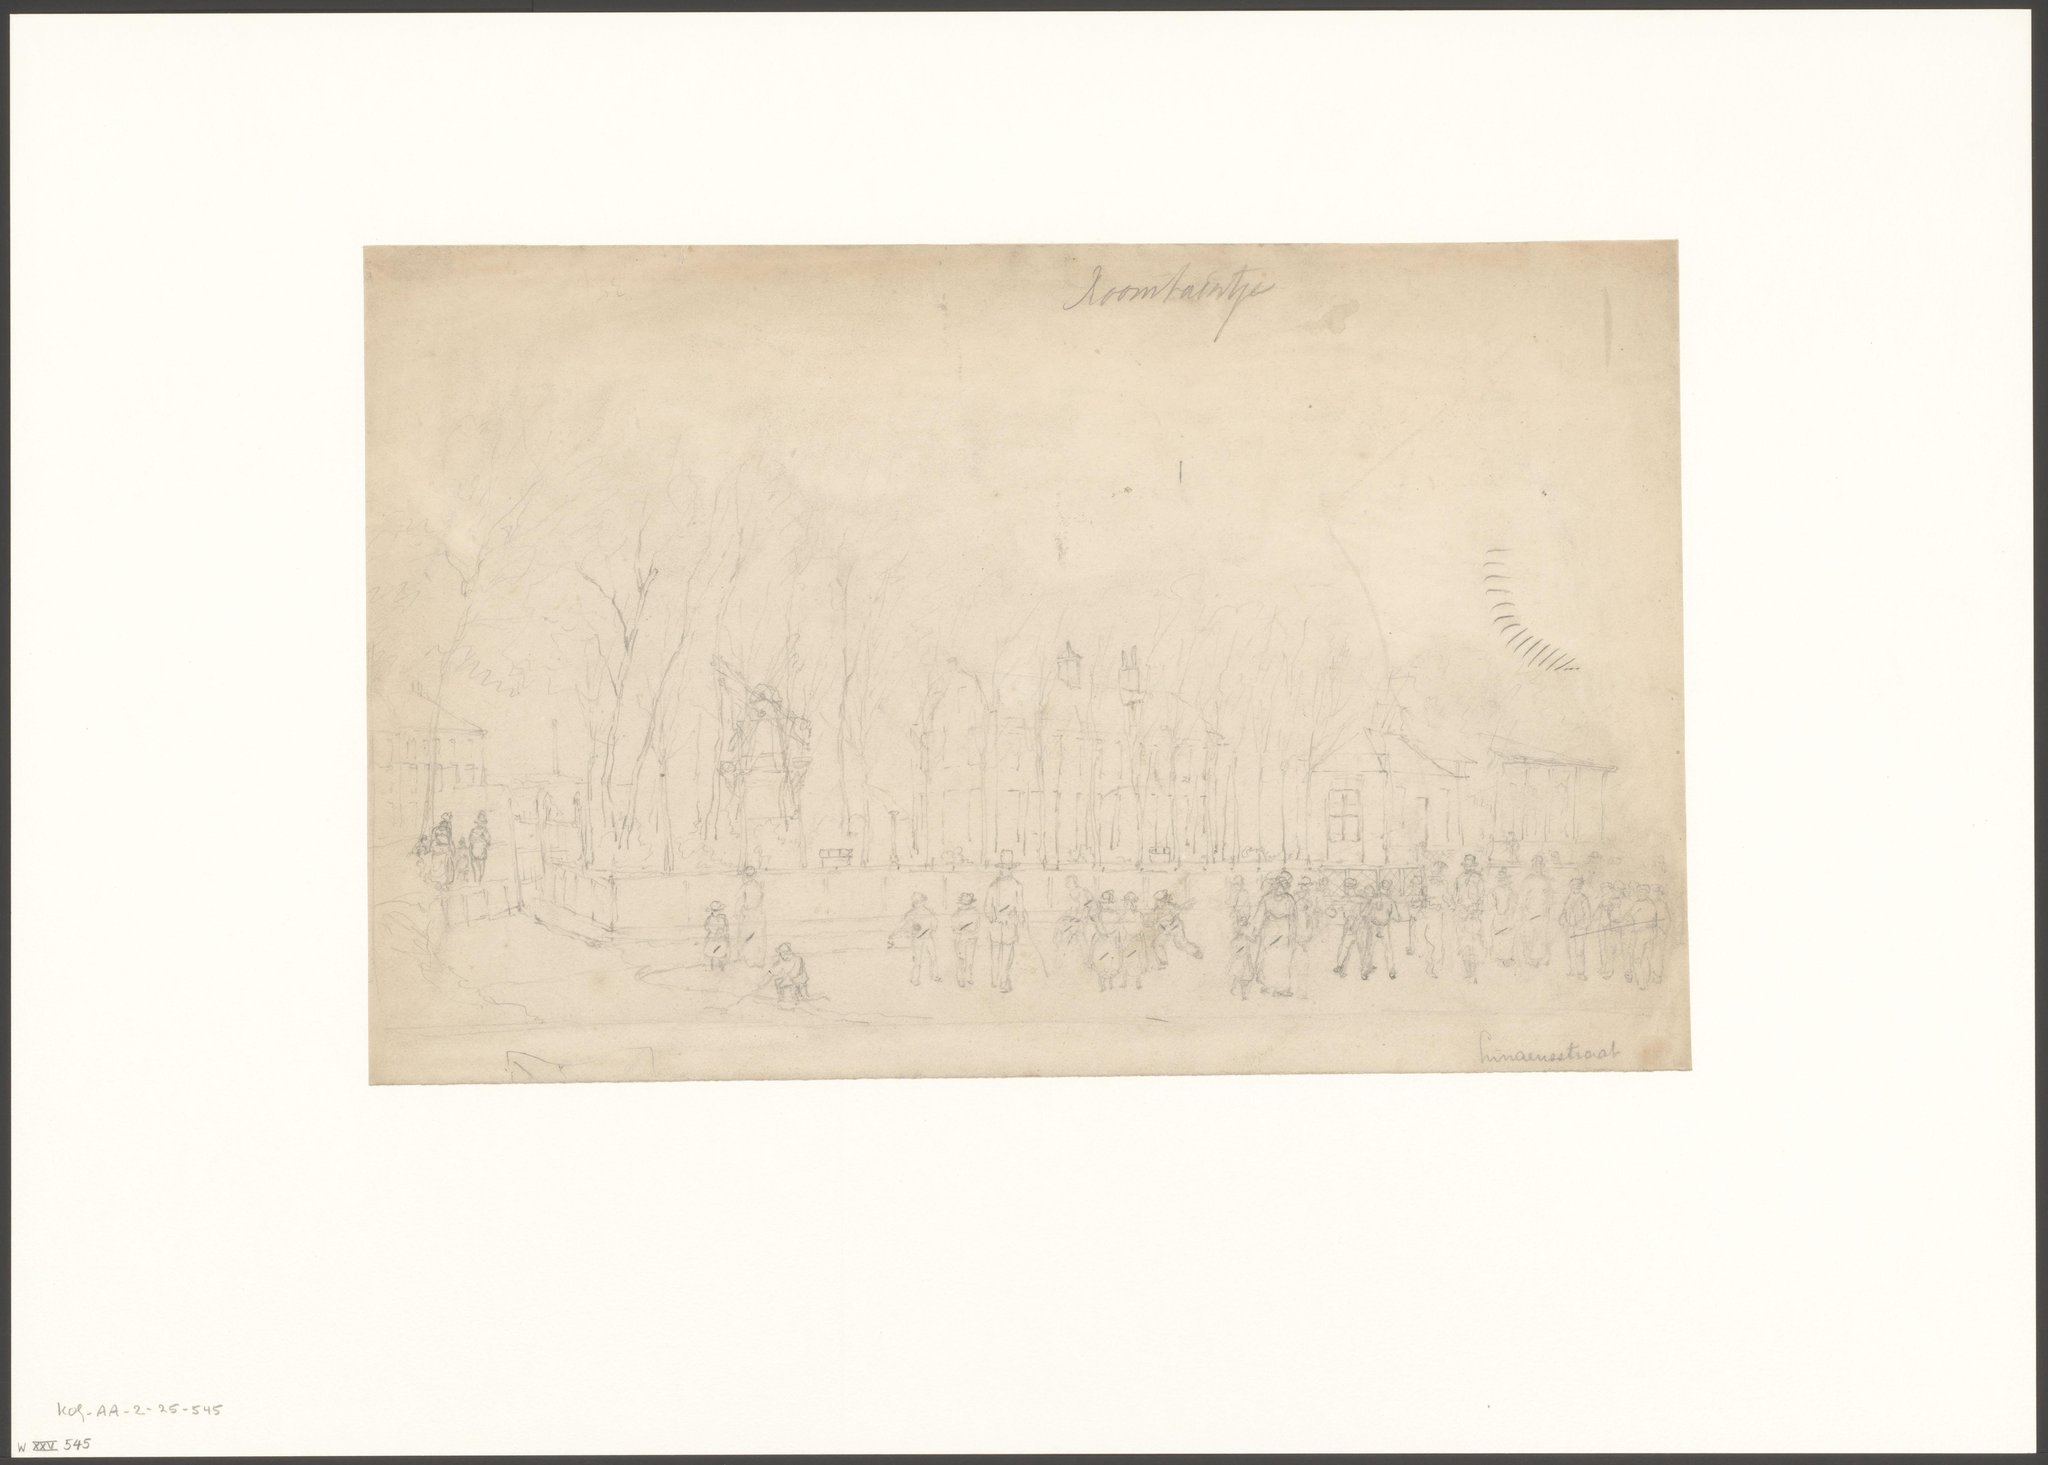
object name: drawing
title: Gezicht op de Linnaeusstraat, hoek Mauritskade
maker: johan martinus anthon rieke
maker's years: 1851-1899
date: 1861-1899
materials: paper, pencil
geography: amsterdam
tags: city-view in general; 'veduta', windmill in landscape, open-air recreation, street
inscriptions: collector's mark: Lugt 800a, inscription: ‘Roomtuintje / Linaeusstraat’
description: Tekening binnen de Atlas Van Eck ingedeeld op wijknummer 25.